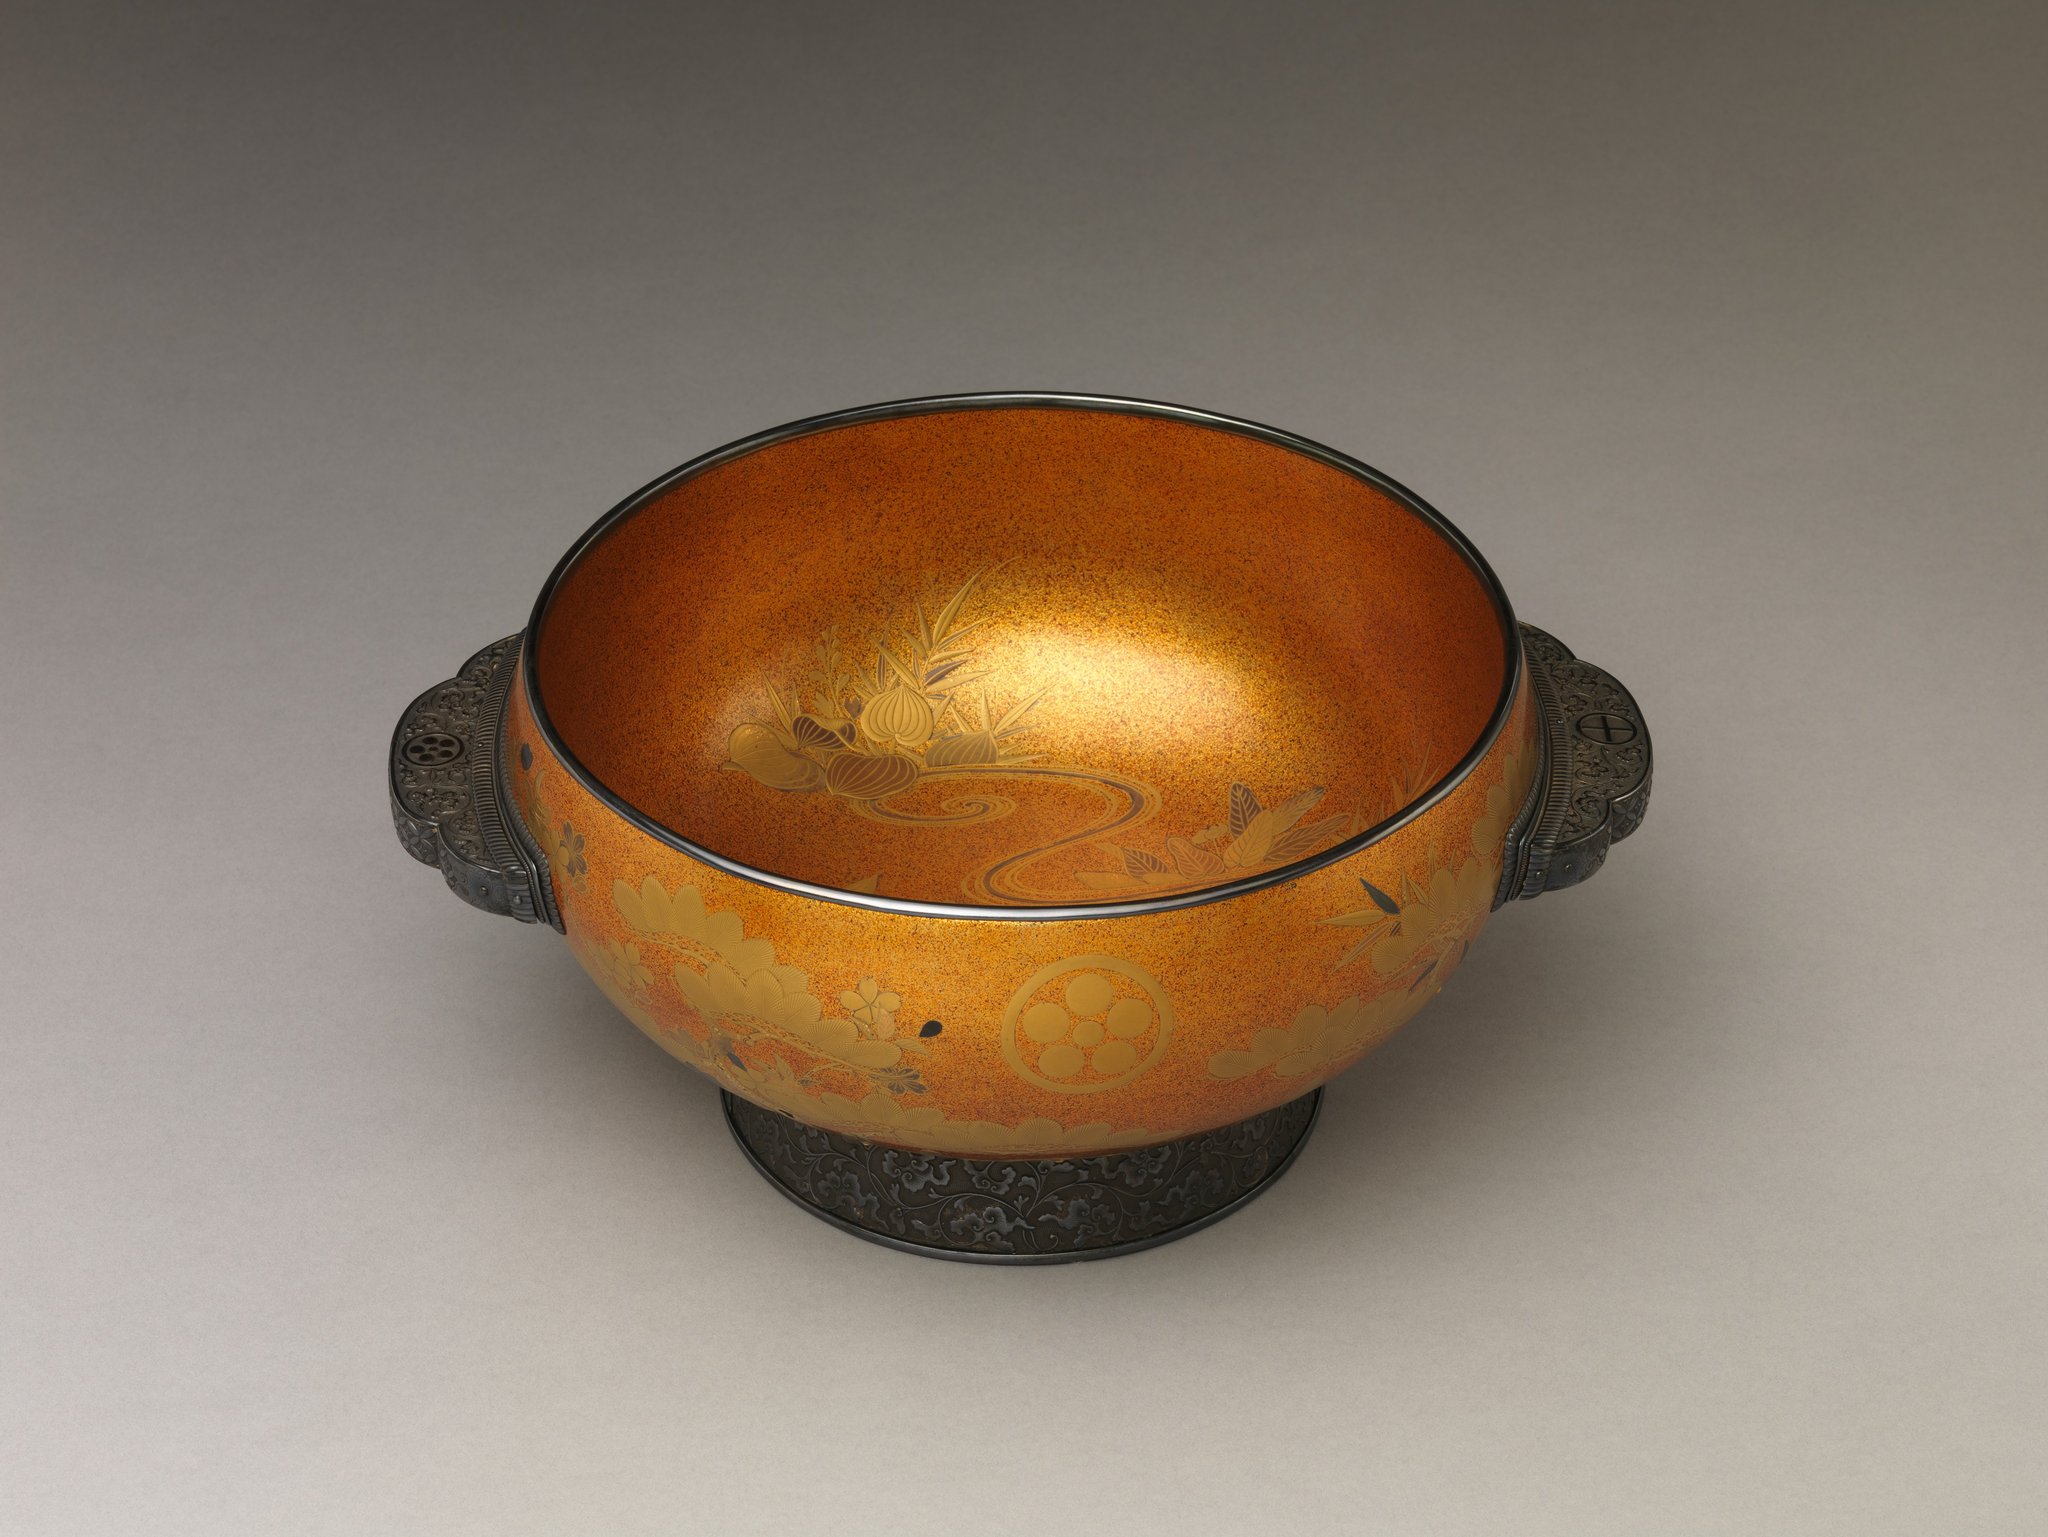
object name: bowl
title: Bowl with Design of Pine, Bamboo, and Cherry Blossom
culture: japanese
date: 1801-1900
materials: gold, lacquer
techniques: maki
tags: flowers